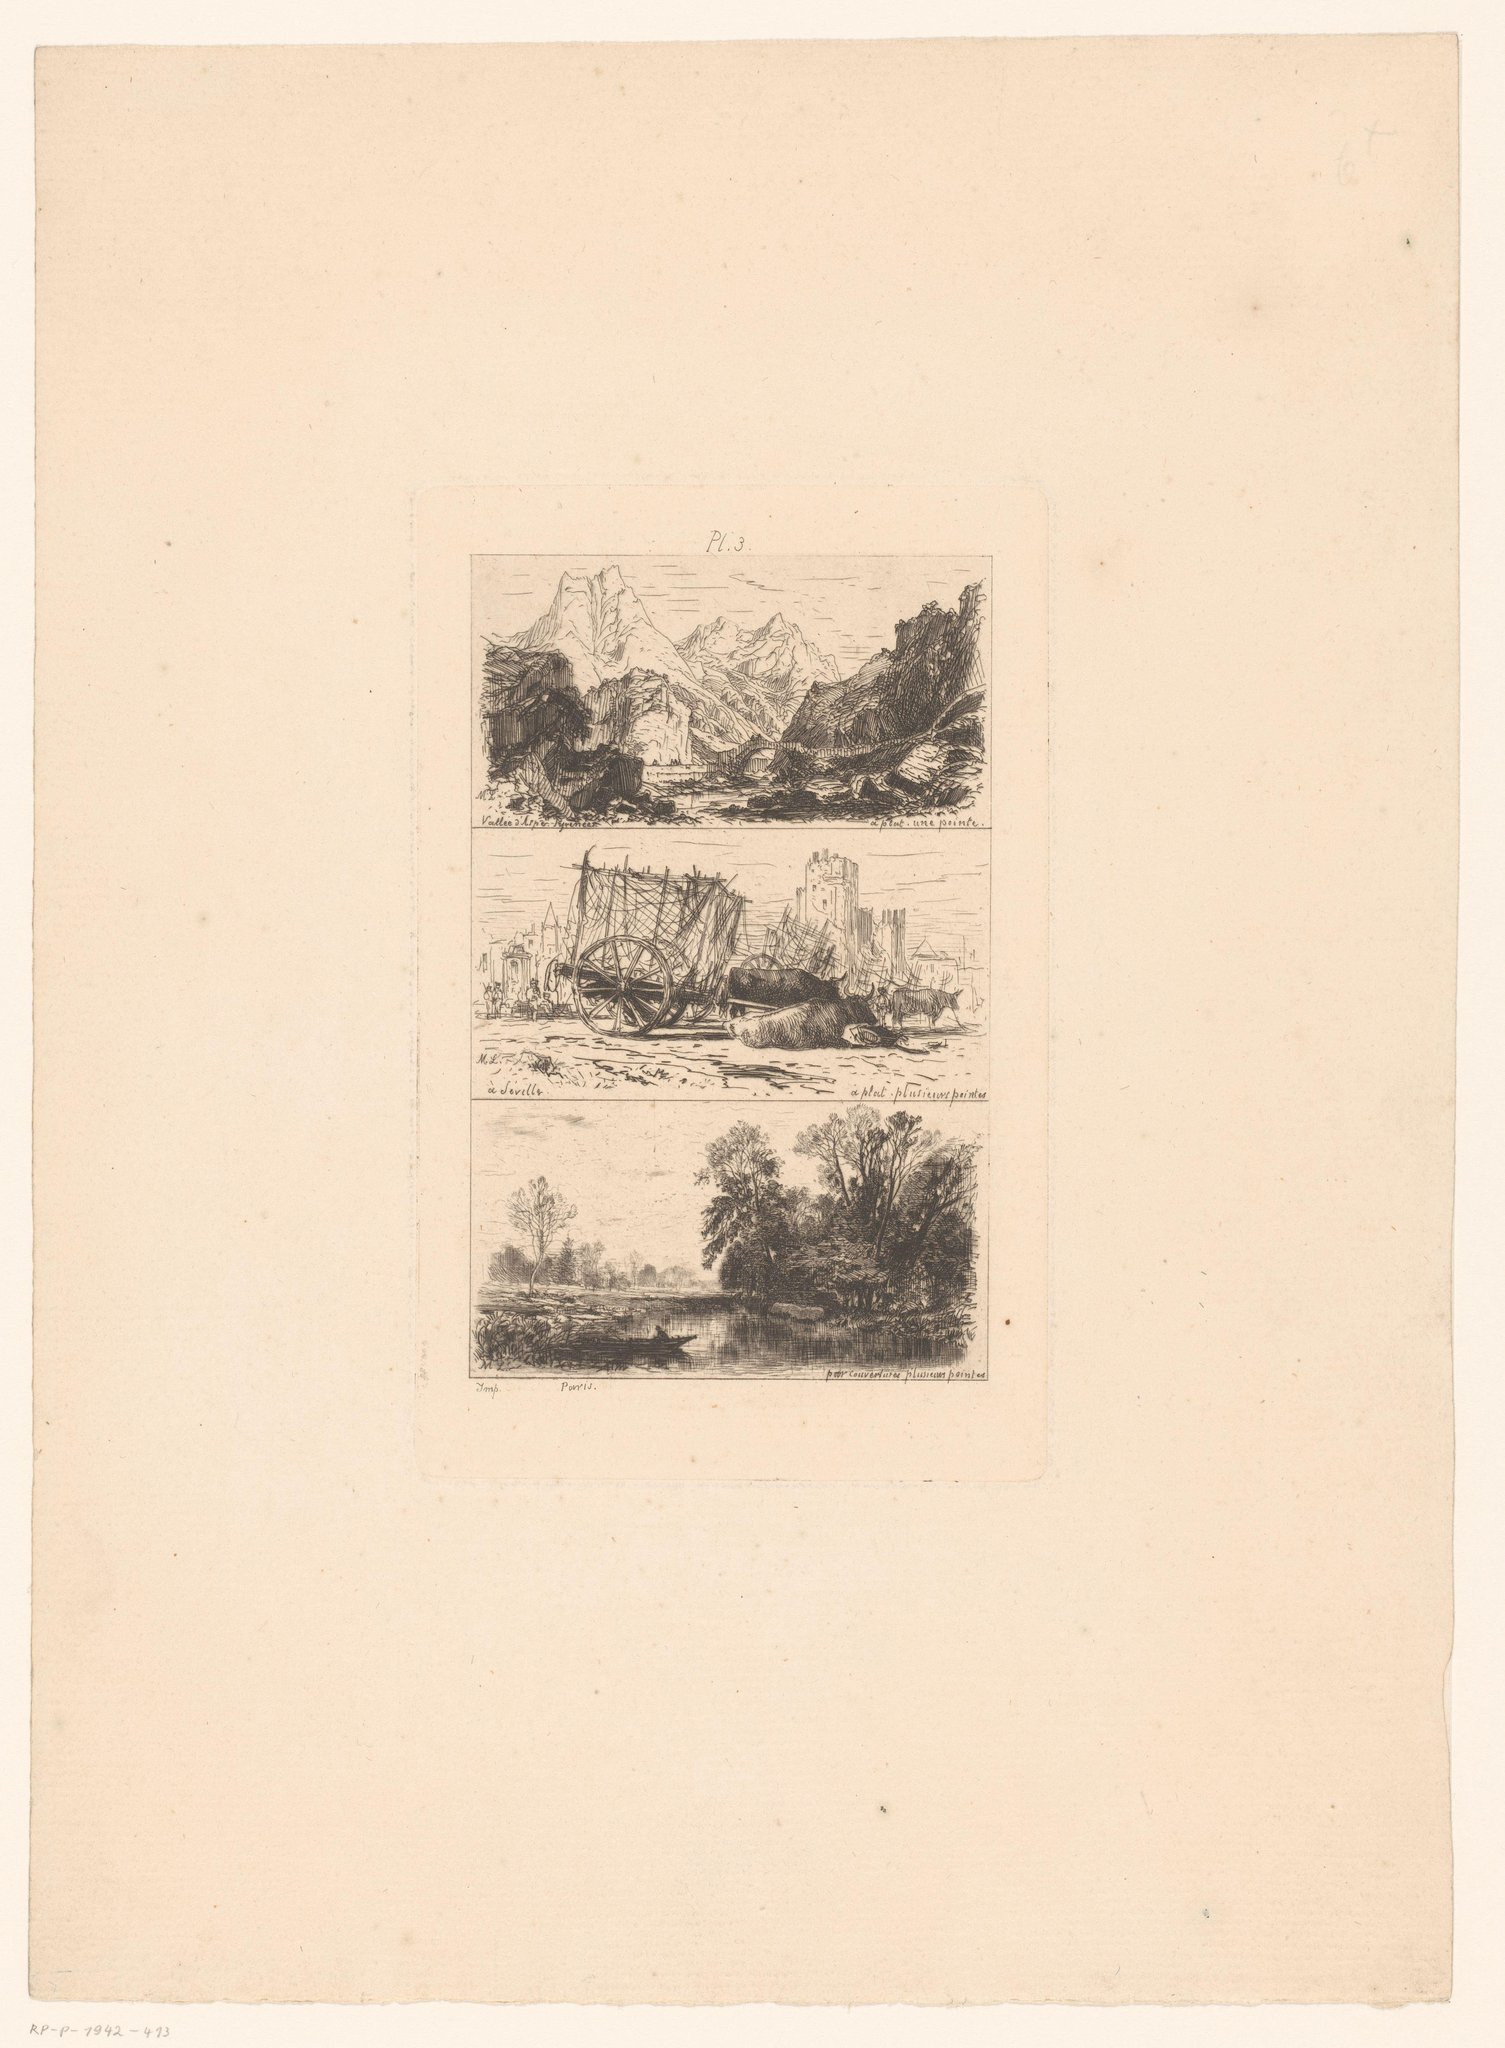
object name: print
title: Schaapherder die op zijn staf leunt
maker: willem witsen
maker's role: draughtsman, painter, print maker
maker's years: 1860-1923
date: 1886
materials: paper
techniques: etching, intaglio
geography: ewijkshoeve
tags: herding, herdsman, herdswoman, shepherd, shepherdess, cowherd, etc., cattle driving, cattle driver, shepherd's crook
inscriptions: signature: ‘Willem Witsen’, collector's mark: Lugt 2228